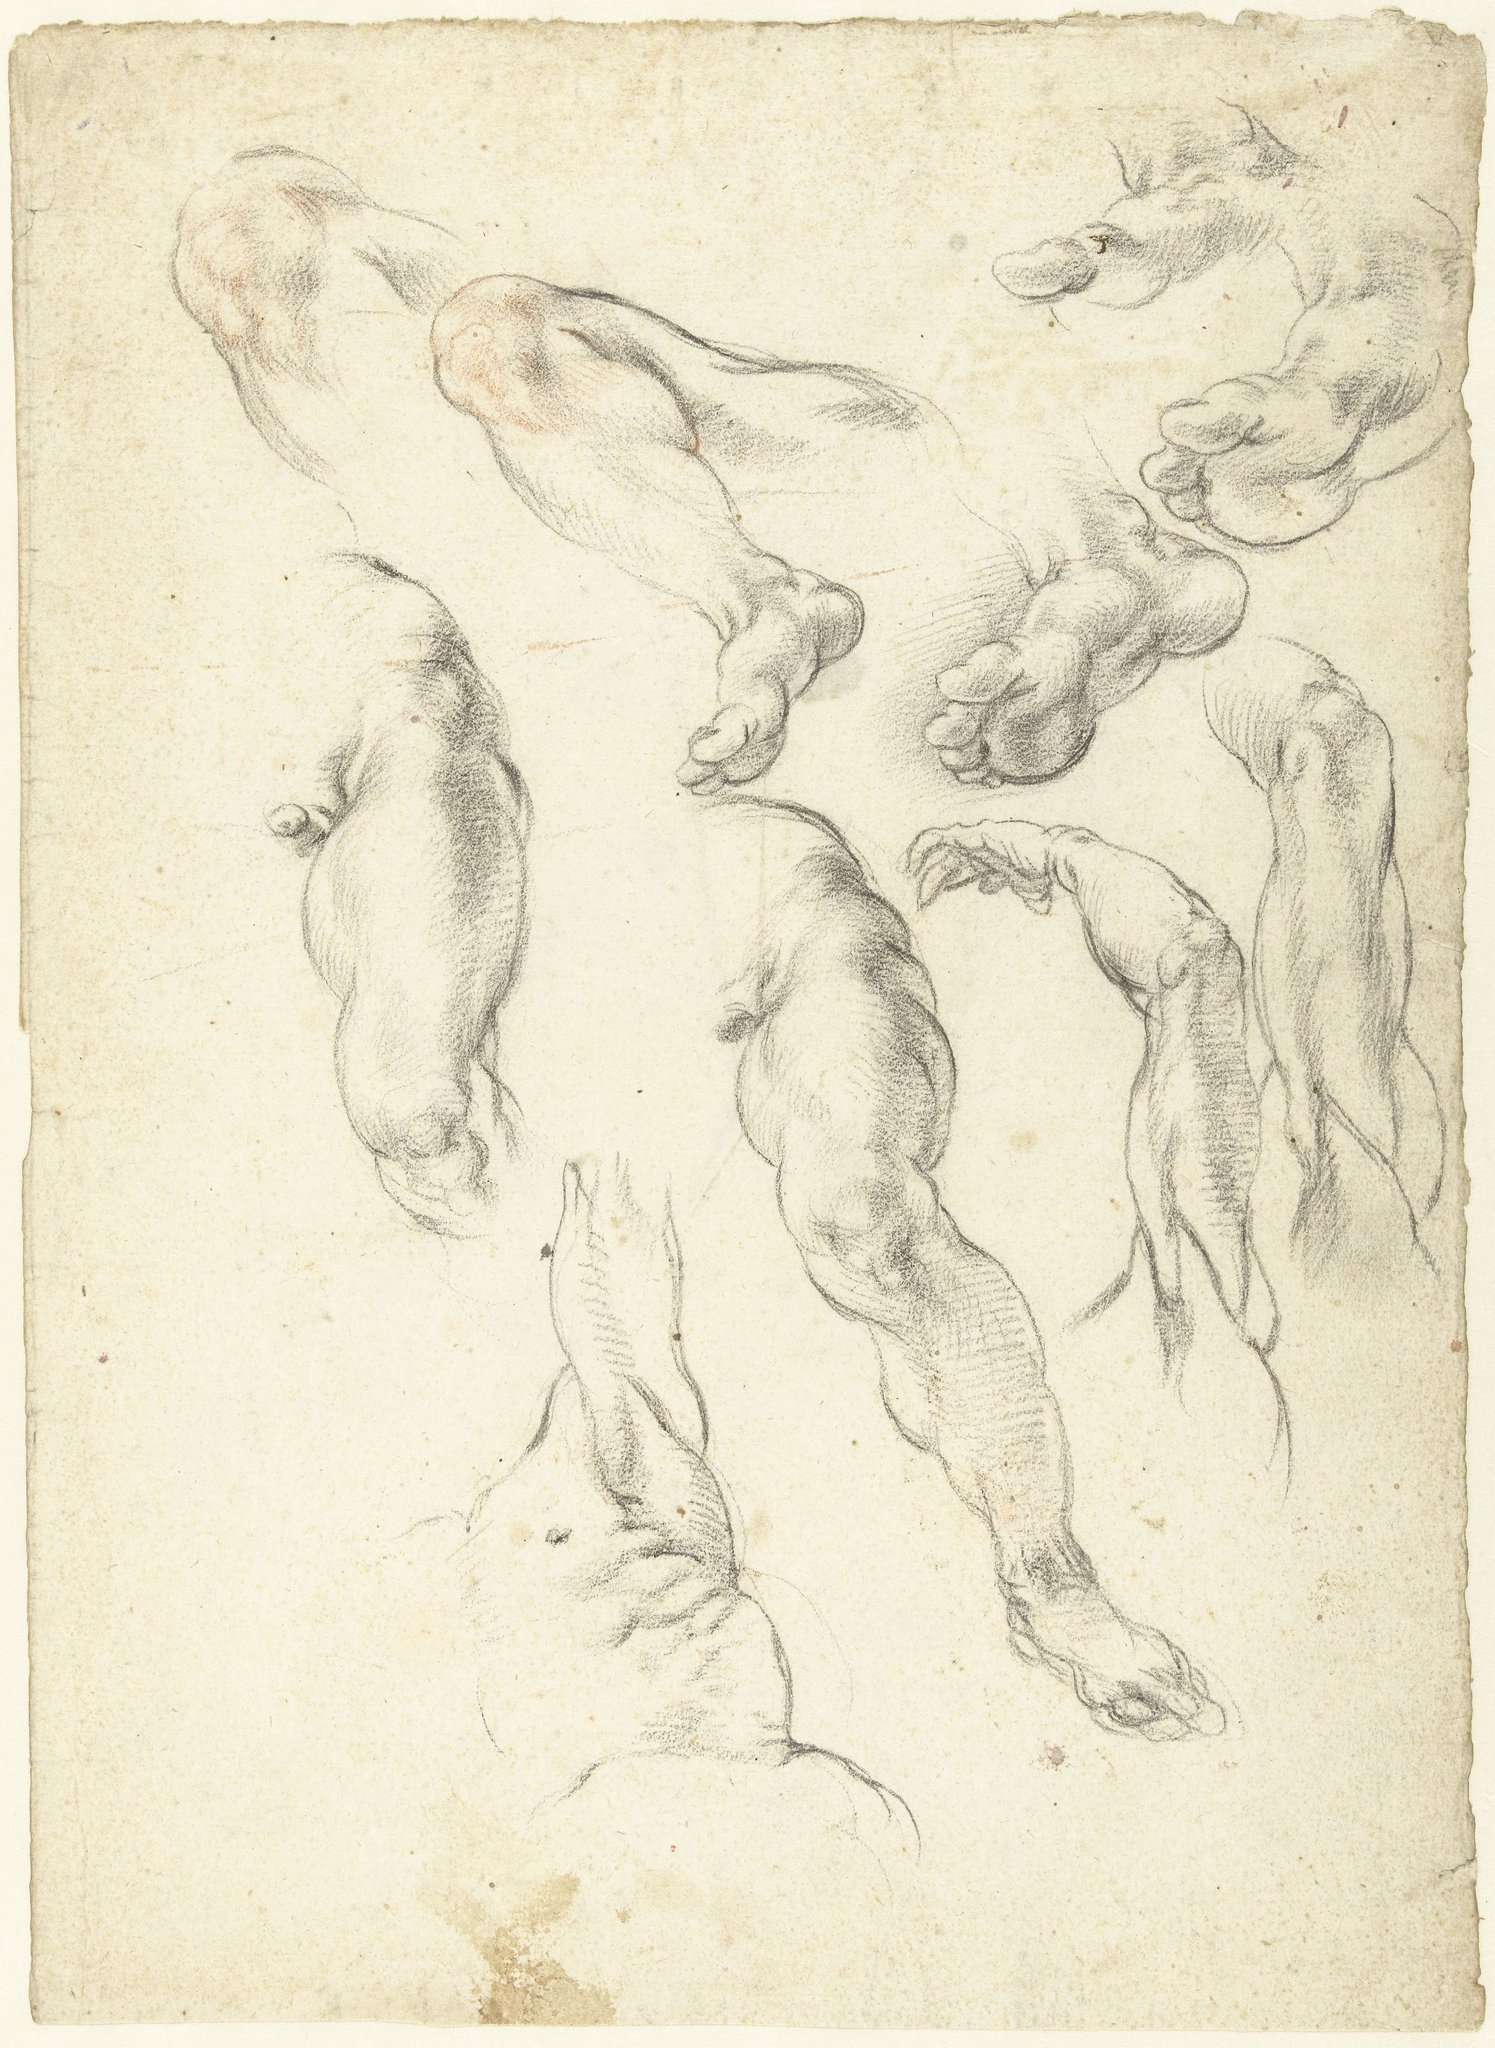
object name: drawing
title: Studieblad met armen en benen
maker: giovanni alberti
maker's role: draughtsman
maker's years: 1558-1601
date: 1568-1601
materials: chalk, paper